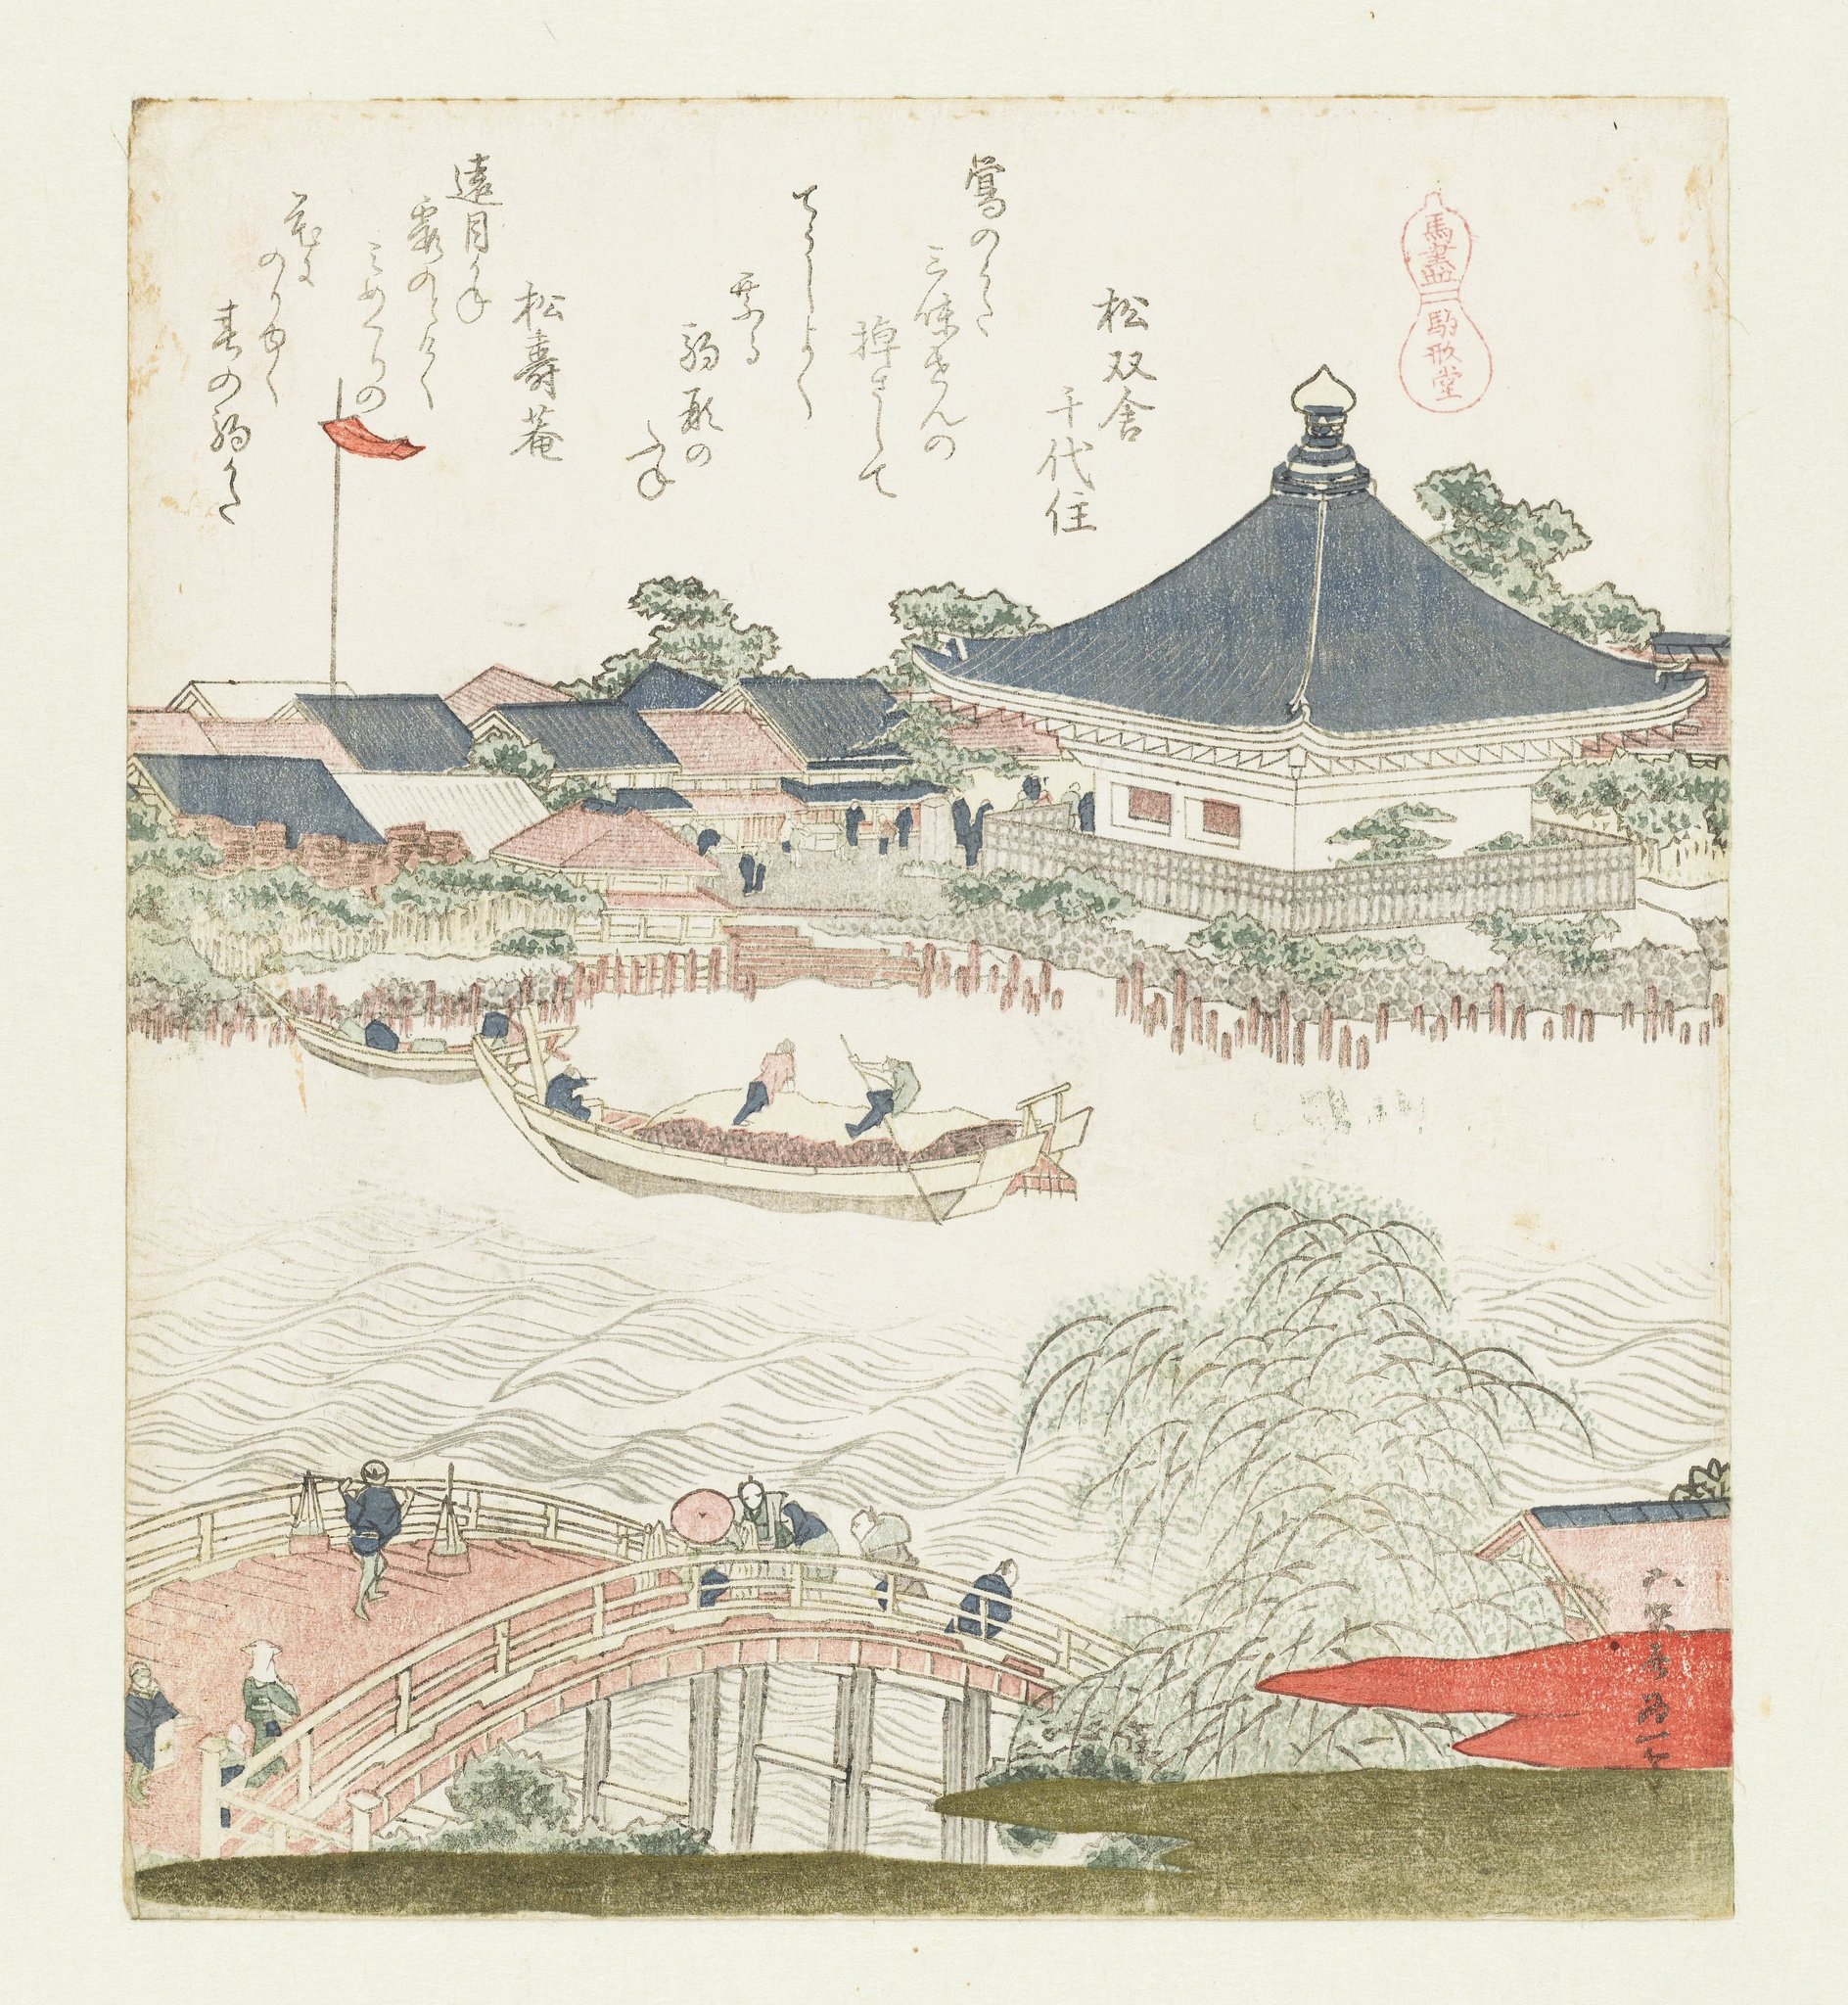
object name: surimono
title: Een serie met paarden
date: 1822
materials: paper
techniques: blind stamped, woodcut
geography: japan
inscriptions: collector's mark, passe-partout, bottom left, printed: JABdH with a rooster., collector's mark, verso, stamped: Lugt 2228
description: Een surimono is een luxe uitgevoerde prent waarop beeld met één of meerdere gedichten gecombineerd is. Bij het drukken van een surimono werd vaak gebruik gemaakt van dikker papier, blinddruk en metaal pigmenten, zoals koper- en zilverpoeder. De prenten werden vaak in opdracht van dichters gemaakt en als exclusief geschenk aan vrienden en relaties gegeven.